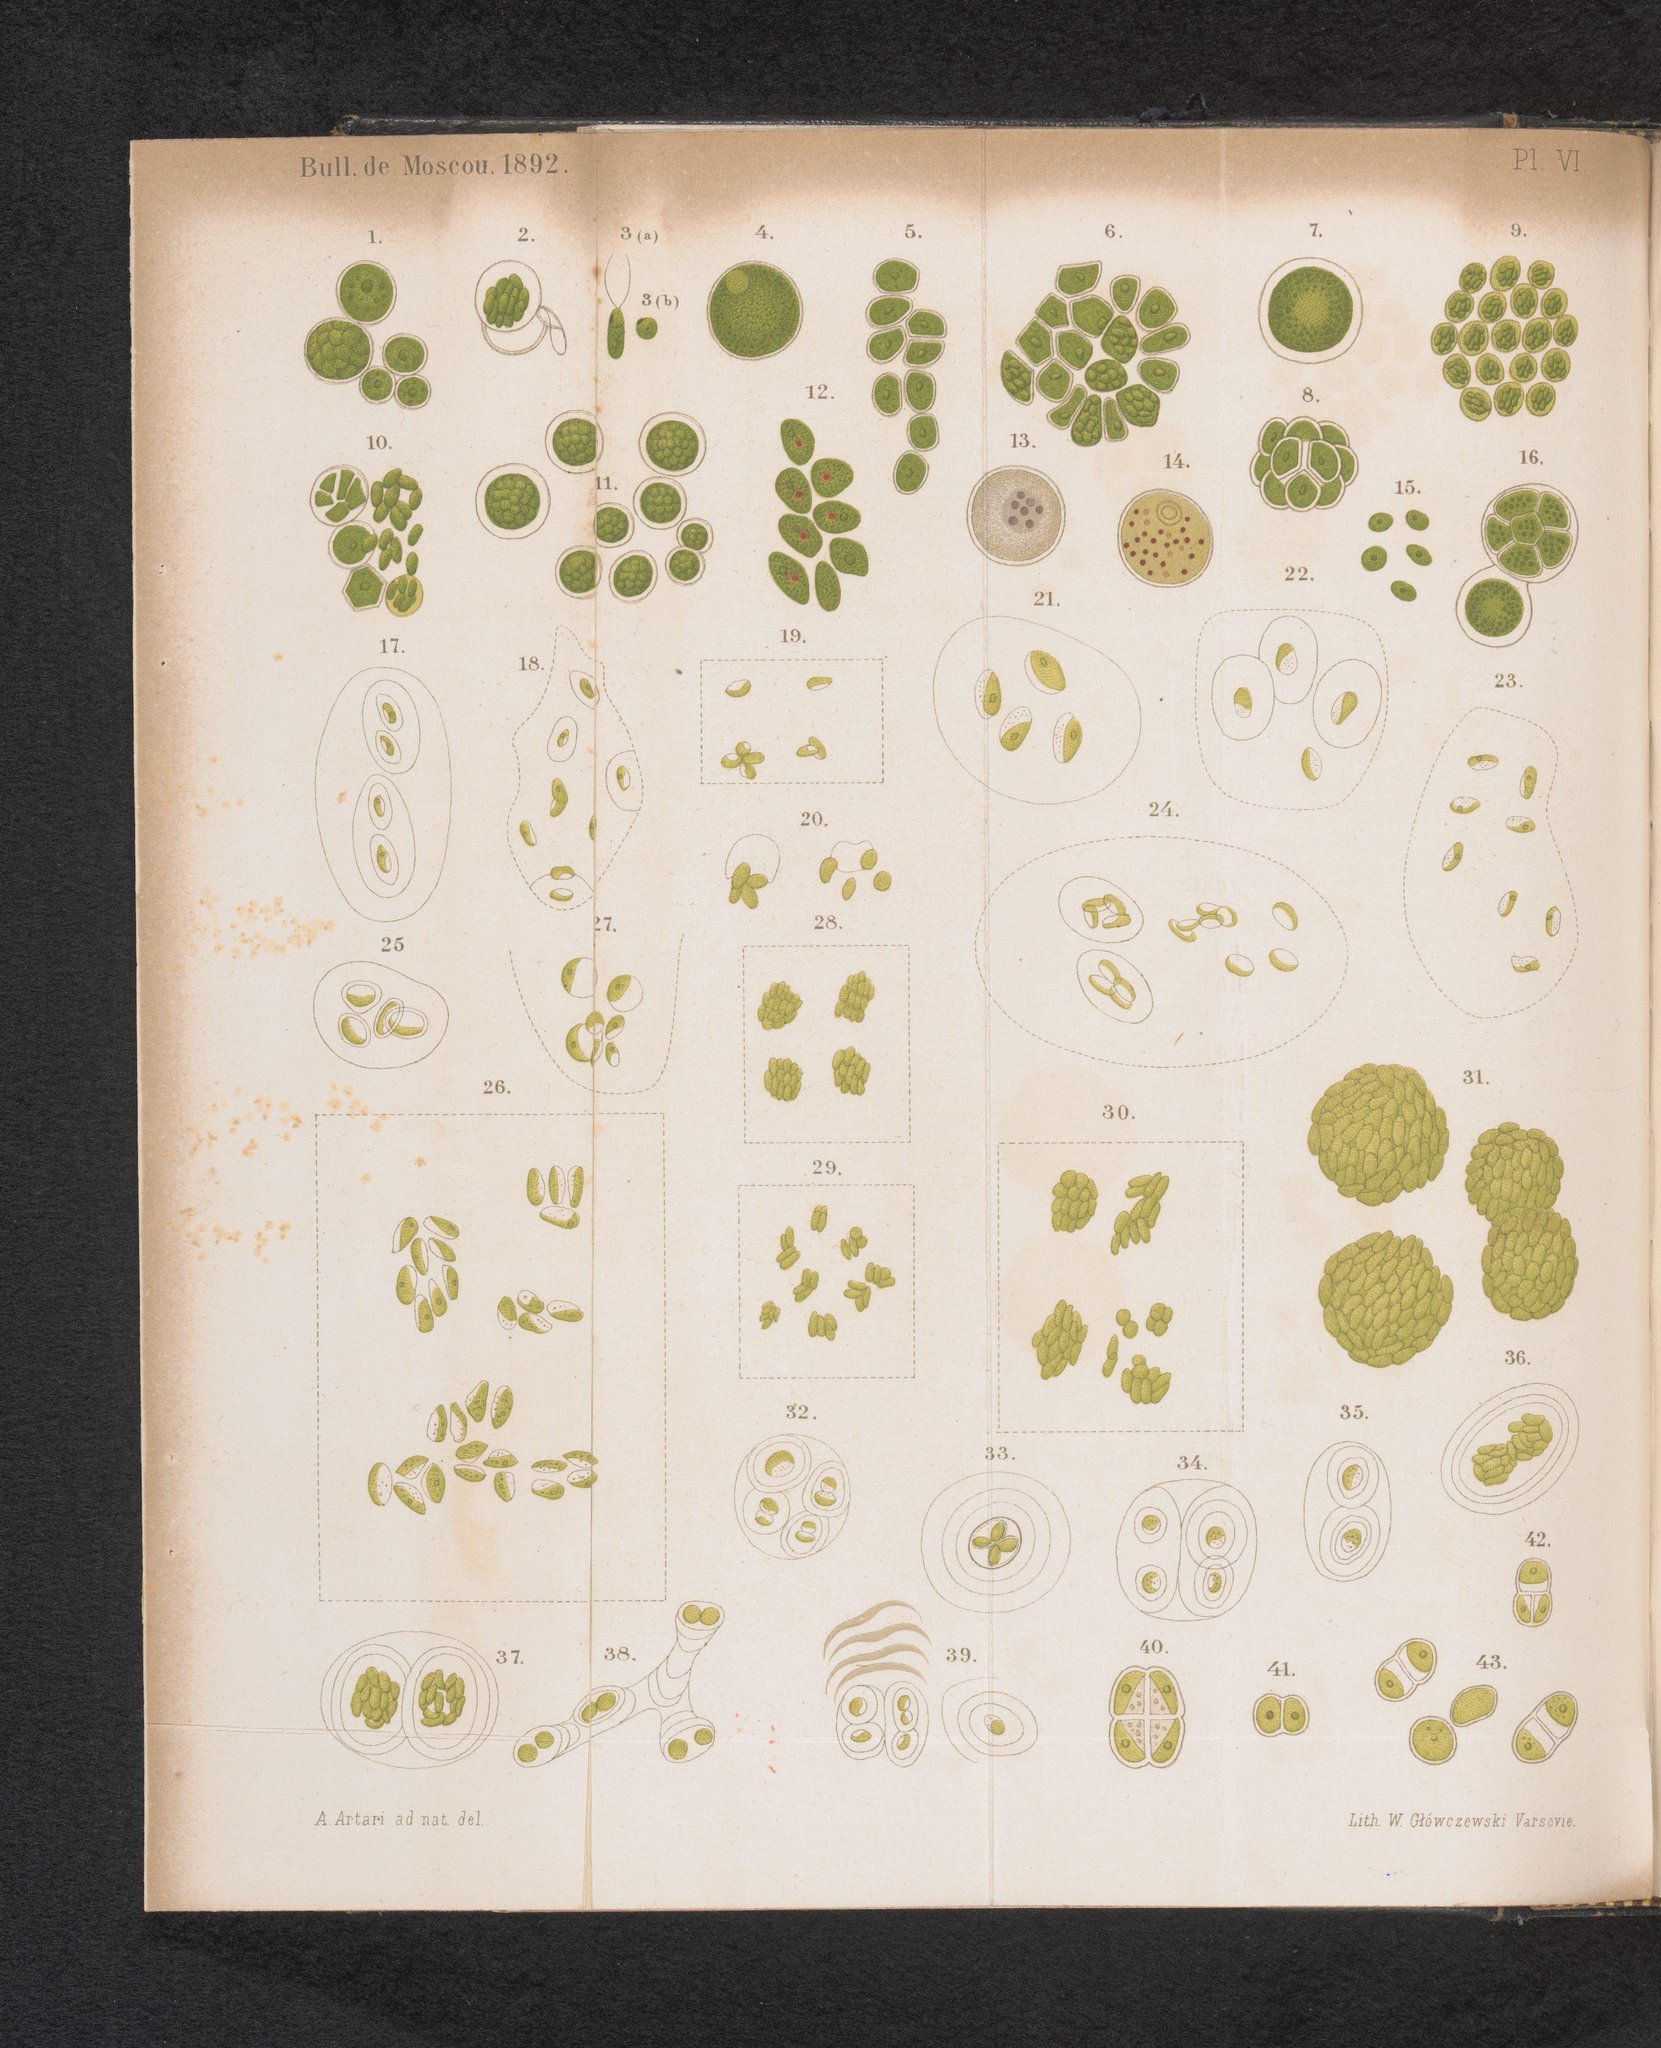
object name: photomechanical print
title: 43 voorstellingen van cellen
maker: w. glówczewski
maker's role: clichémaker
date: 1888-1893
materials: paper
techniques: lithograph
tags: biology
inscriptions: inscription: ‘A. Atari ad nat del’